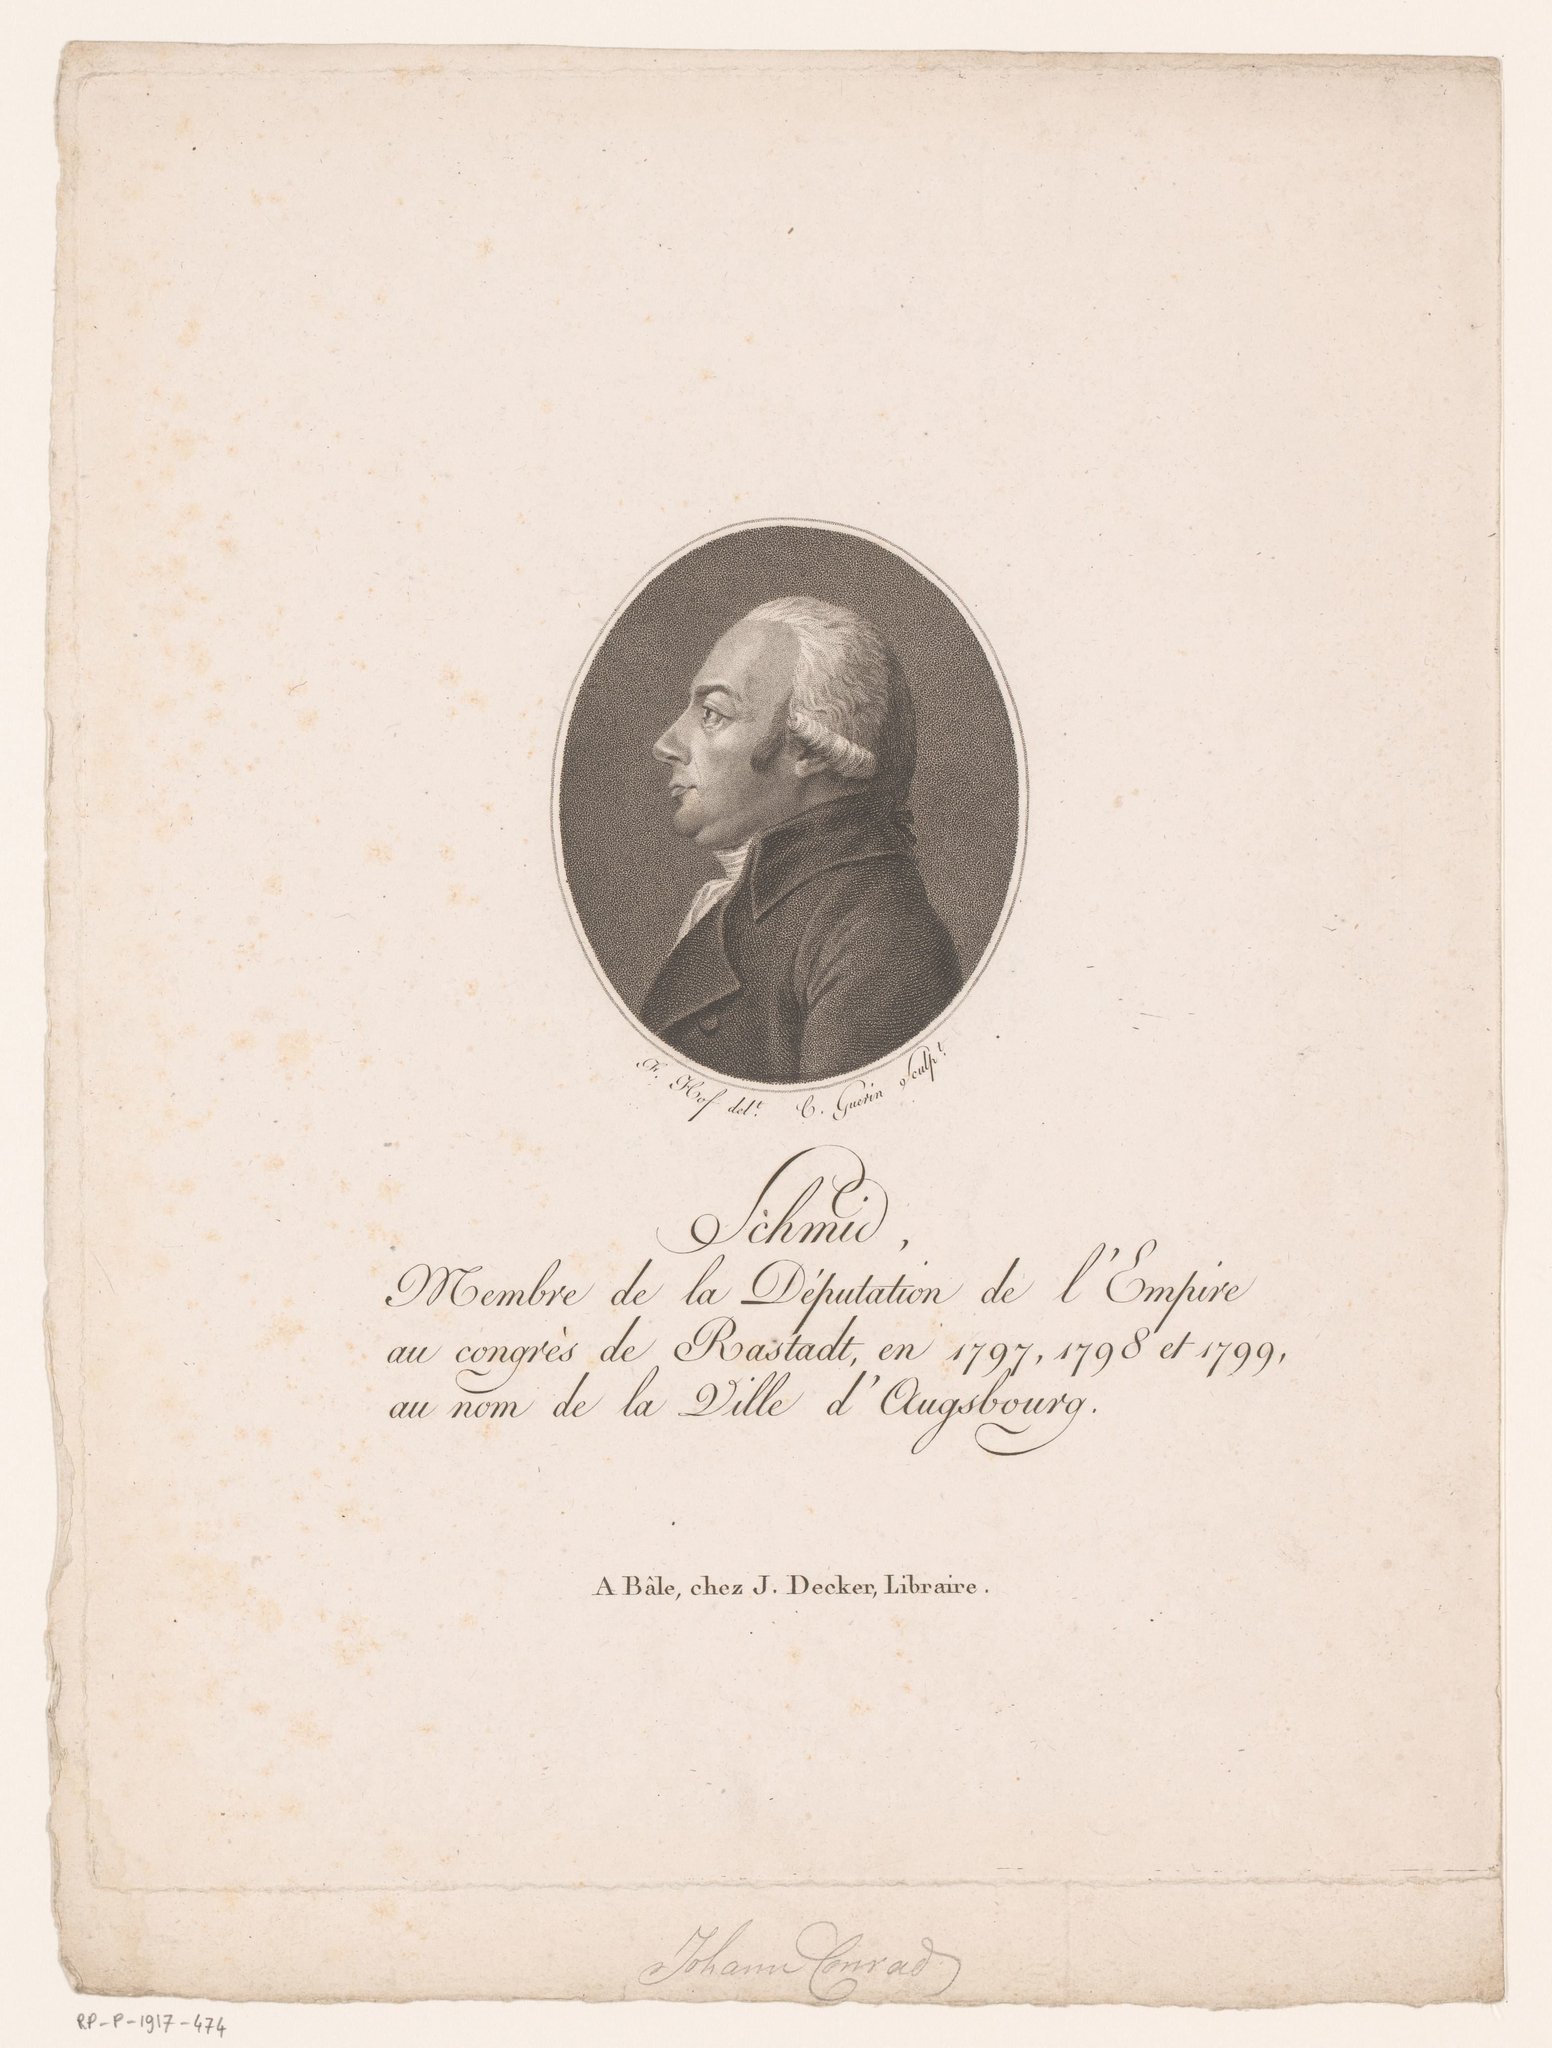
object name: print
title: Portret van Johann Konrad Schmidt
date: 1768-1831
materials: paper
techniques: engraving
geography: basel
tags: historical persons, diplomacy, diplomat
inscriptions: collector's mark: Lugt 2228